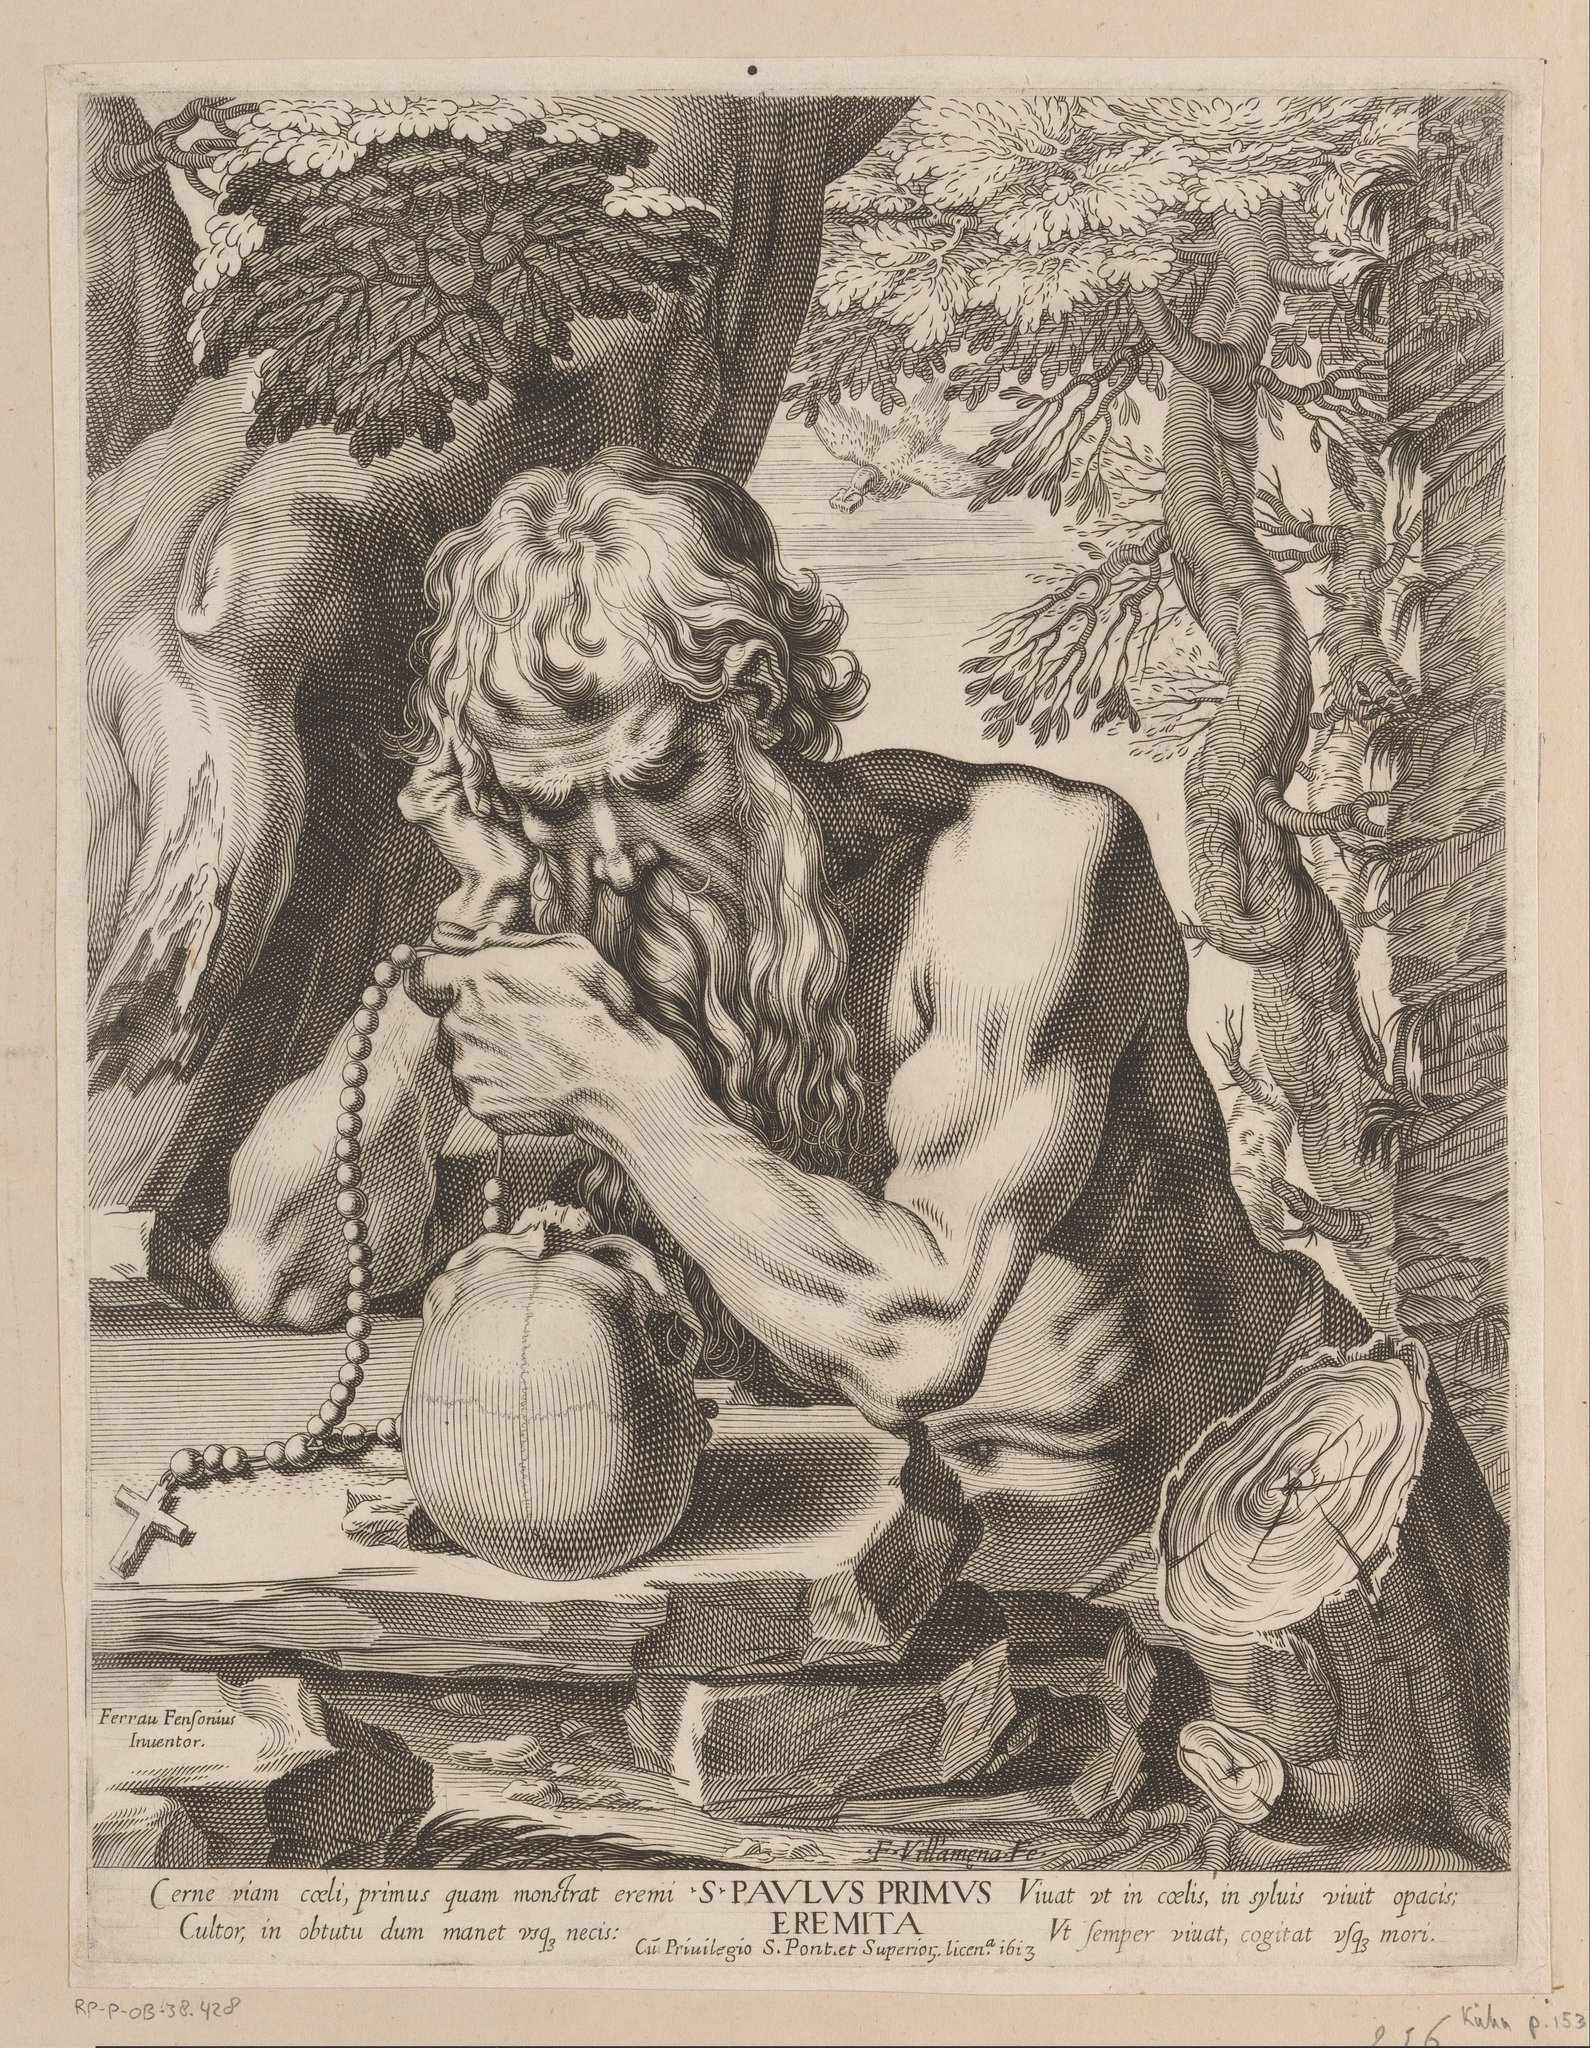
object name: print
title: Paulus de Kluizenaar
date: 1613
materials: paper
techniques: engraving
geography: vatican city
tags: paul of thebes, the first hermit; possible attributes: raven, two lions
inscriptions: collector's mark: Lugt 240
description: De heilige Paulus de Kluizenaar met rozenkrans en doodskop. Twee kolommen Latijnse tekst in ondermarge.